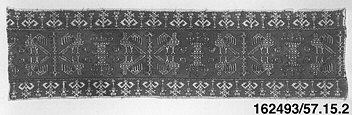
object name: panel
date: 1601-1800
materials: linen, silk